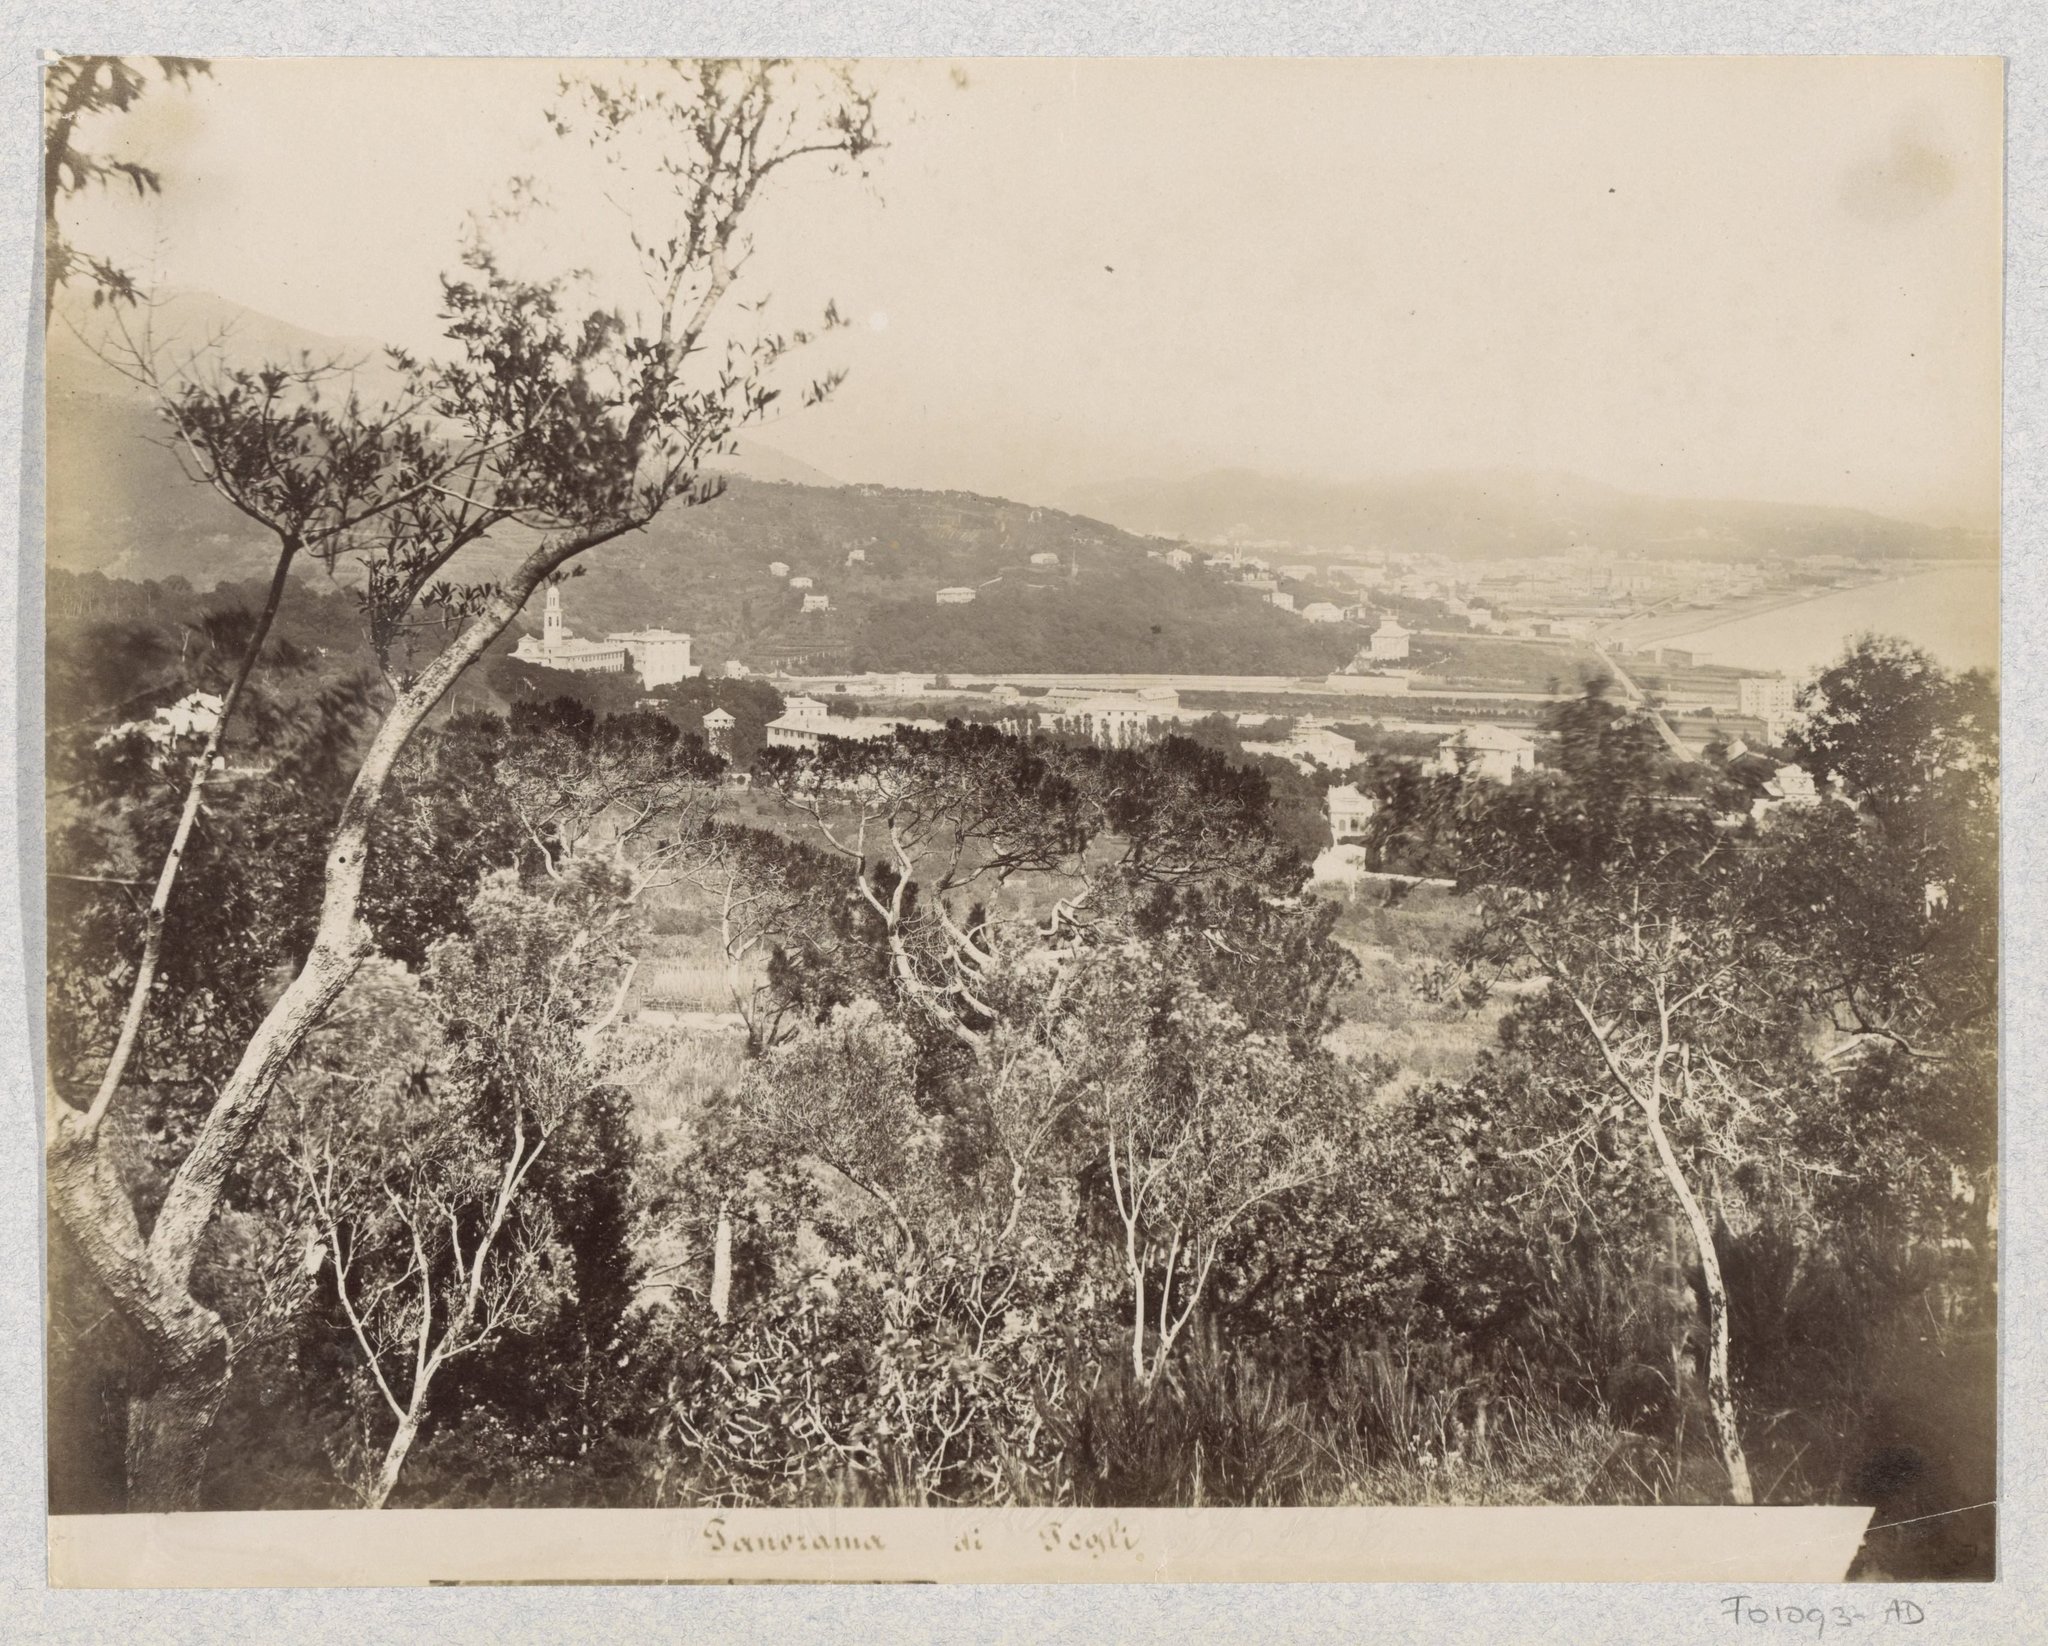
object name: photograph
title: Panorama de Pegli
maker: celestino degoix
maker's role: fotograaf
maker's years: 1825-1902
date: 1870-1890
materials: paper, photographic support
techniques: albumen print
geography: pegli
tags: prospect of village, silhouette of village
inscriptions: stamp: ‘Degoix, C. Photographe du Roi Via Nuovissima N. 7 Genova’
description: Onderdeel van Reisalbum met foto's van bezienswaardigheden in Genua, Florence en Venetië.